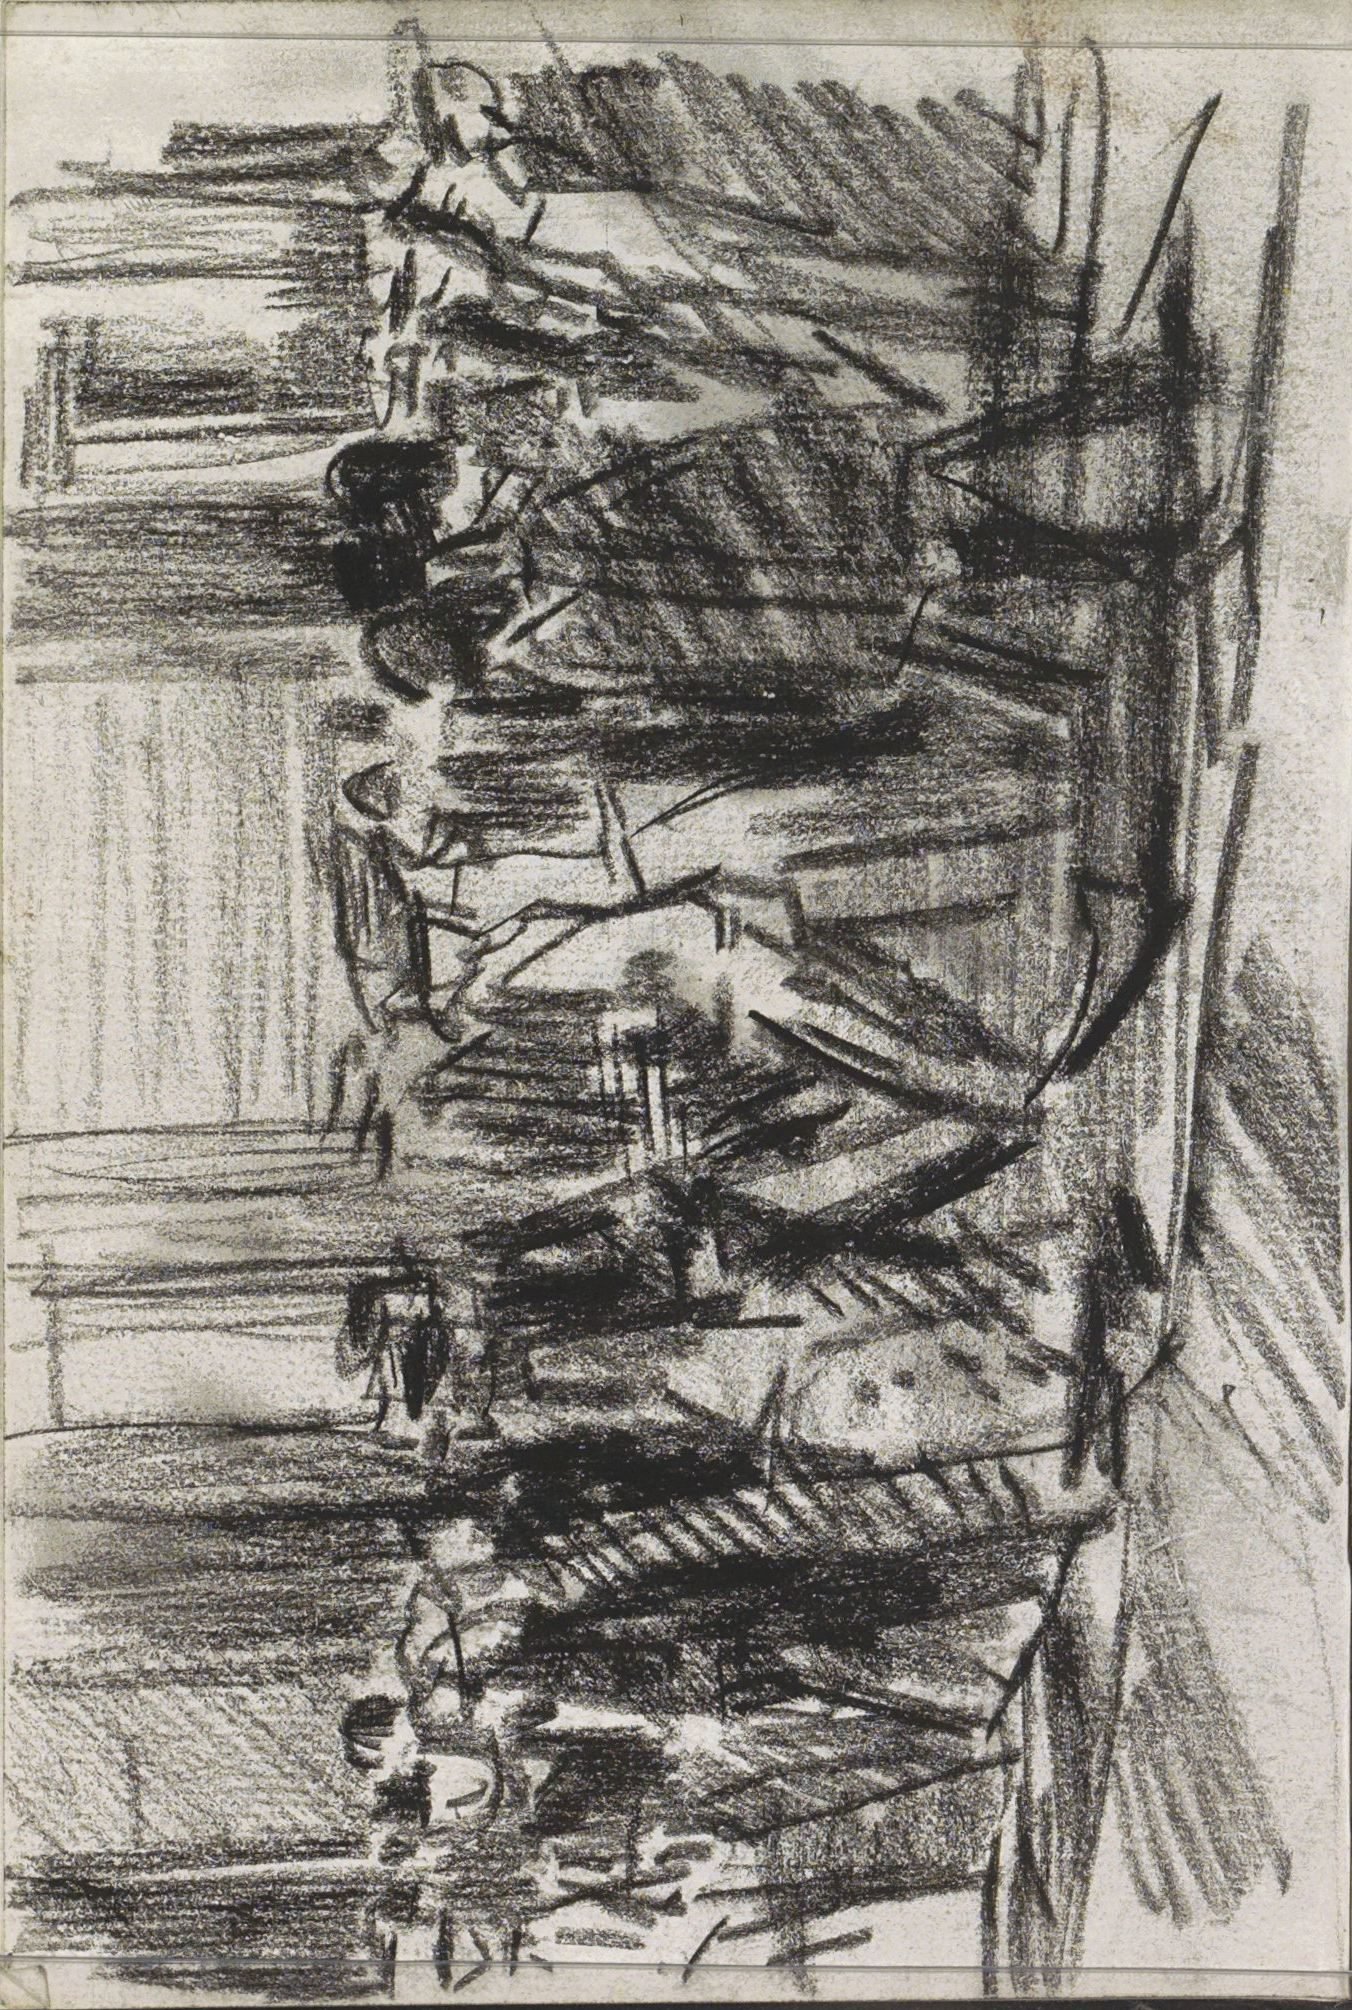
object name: sketchbook leaf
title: Vrouwen en mannen op straat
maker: isaac israels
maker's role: draughtsman, painter, print maker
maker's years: 1865-1934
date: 1875-1934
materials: chalk, paper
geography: the hague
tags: adult woman, adult man, street (+ city(-scape) with figures, staffage)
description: Pagina 25 uit schetsboek XLIV met 43 pagina's.